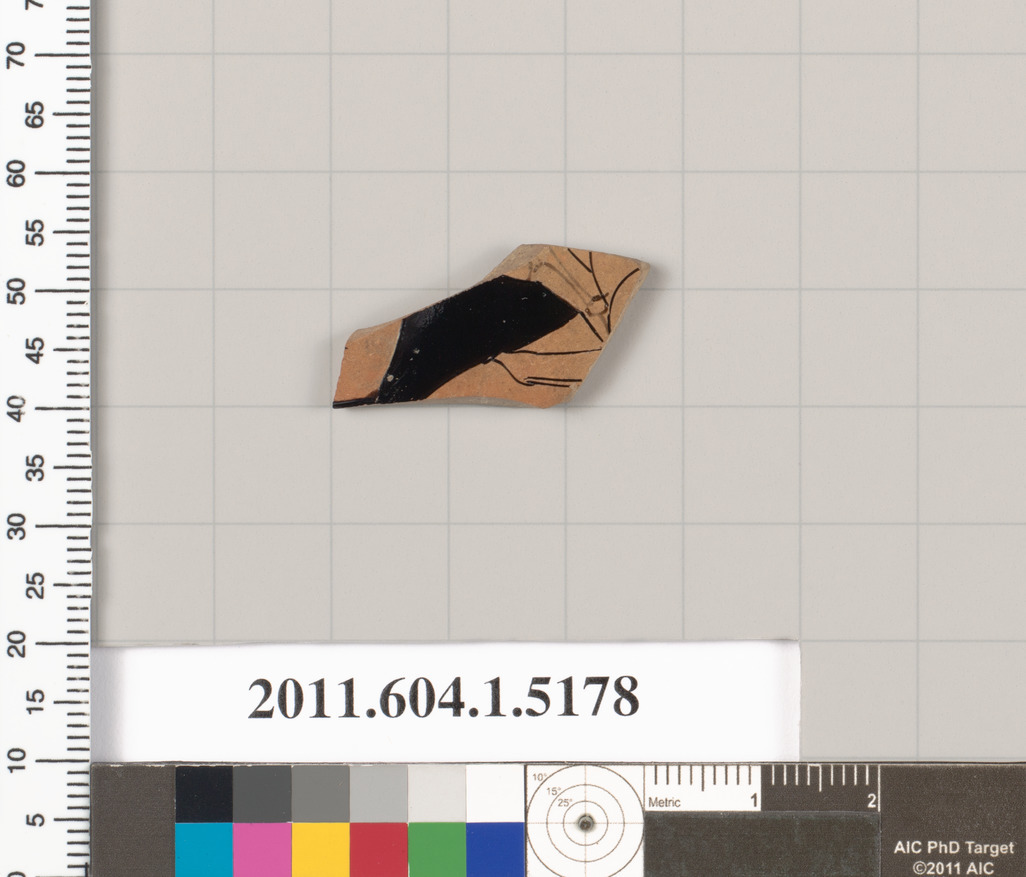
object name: kylix fragment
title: Terracotta fragment of a kylix (drinking cup)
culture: greek, attic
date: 520-500 BCE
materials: terracotta